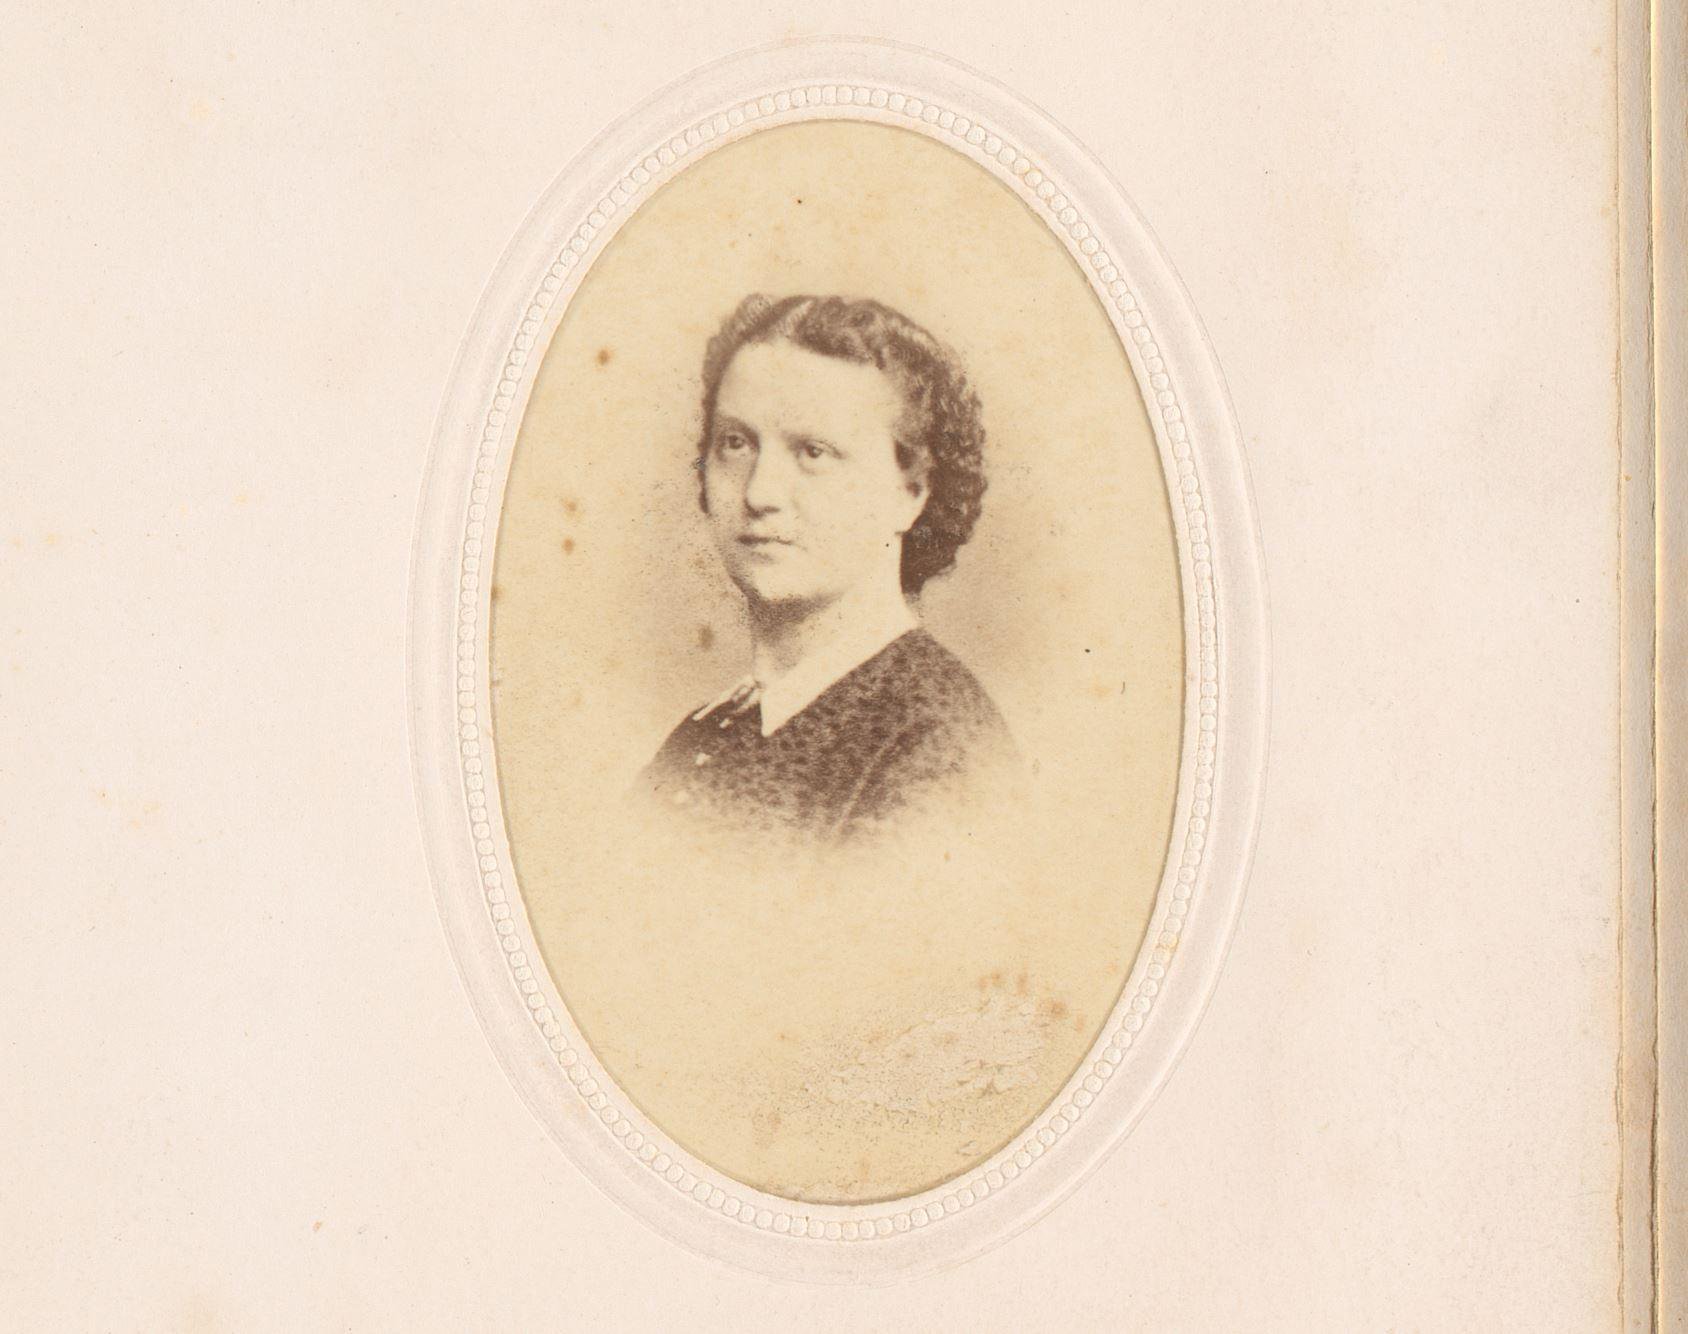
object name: photograph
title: Portret van een vrouw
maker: Anonymous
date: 1860-1890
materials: cardboard, photographic support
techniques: albumen print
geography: netherlands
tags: historical persons - bb - woman